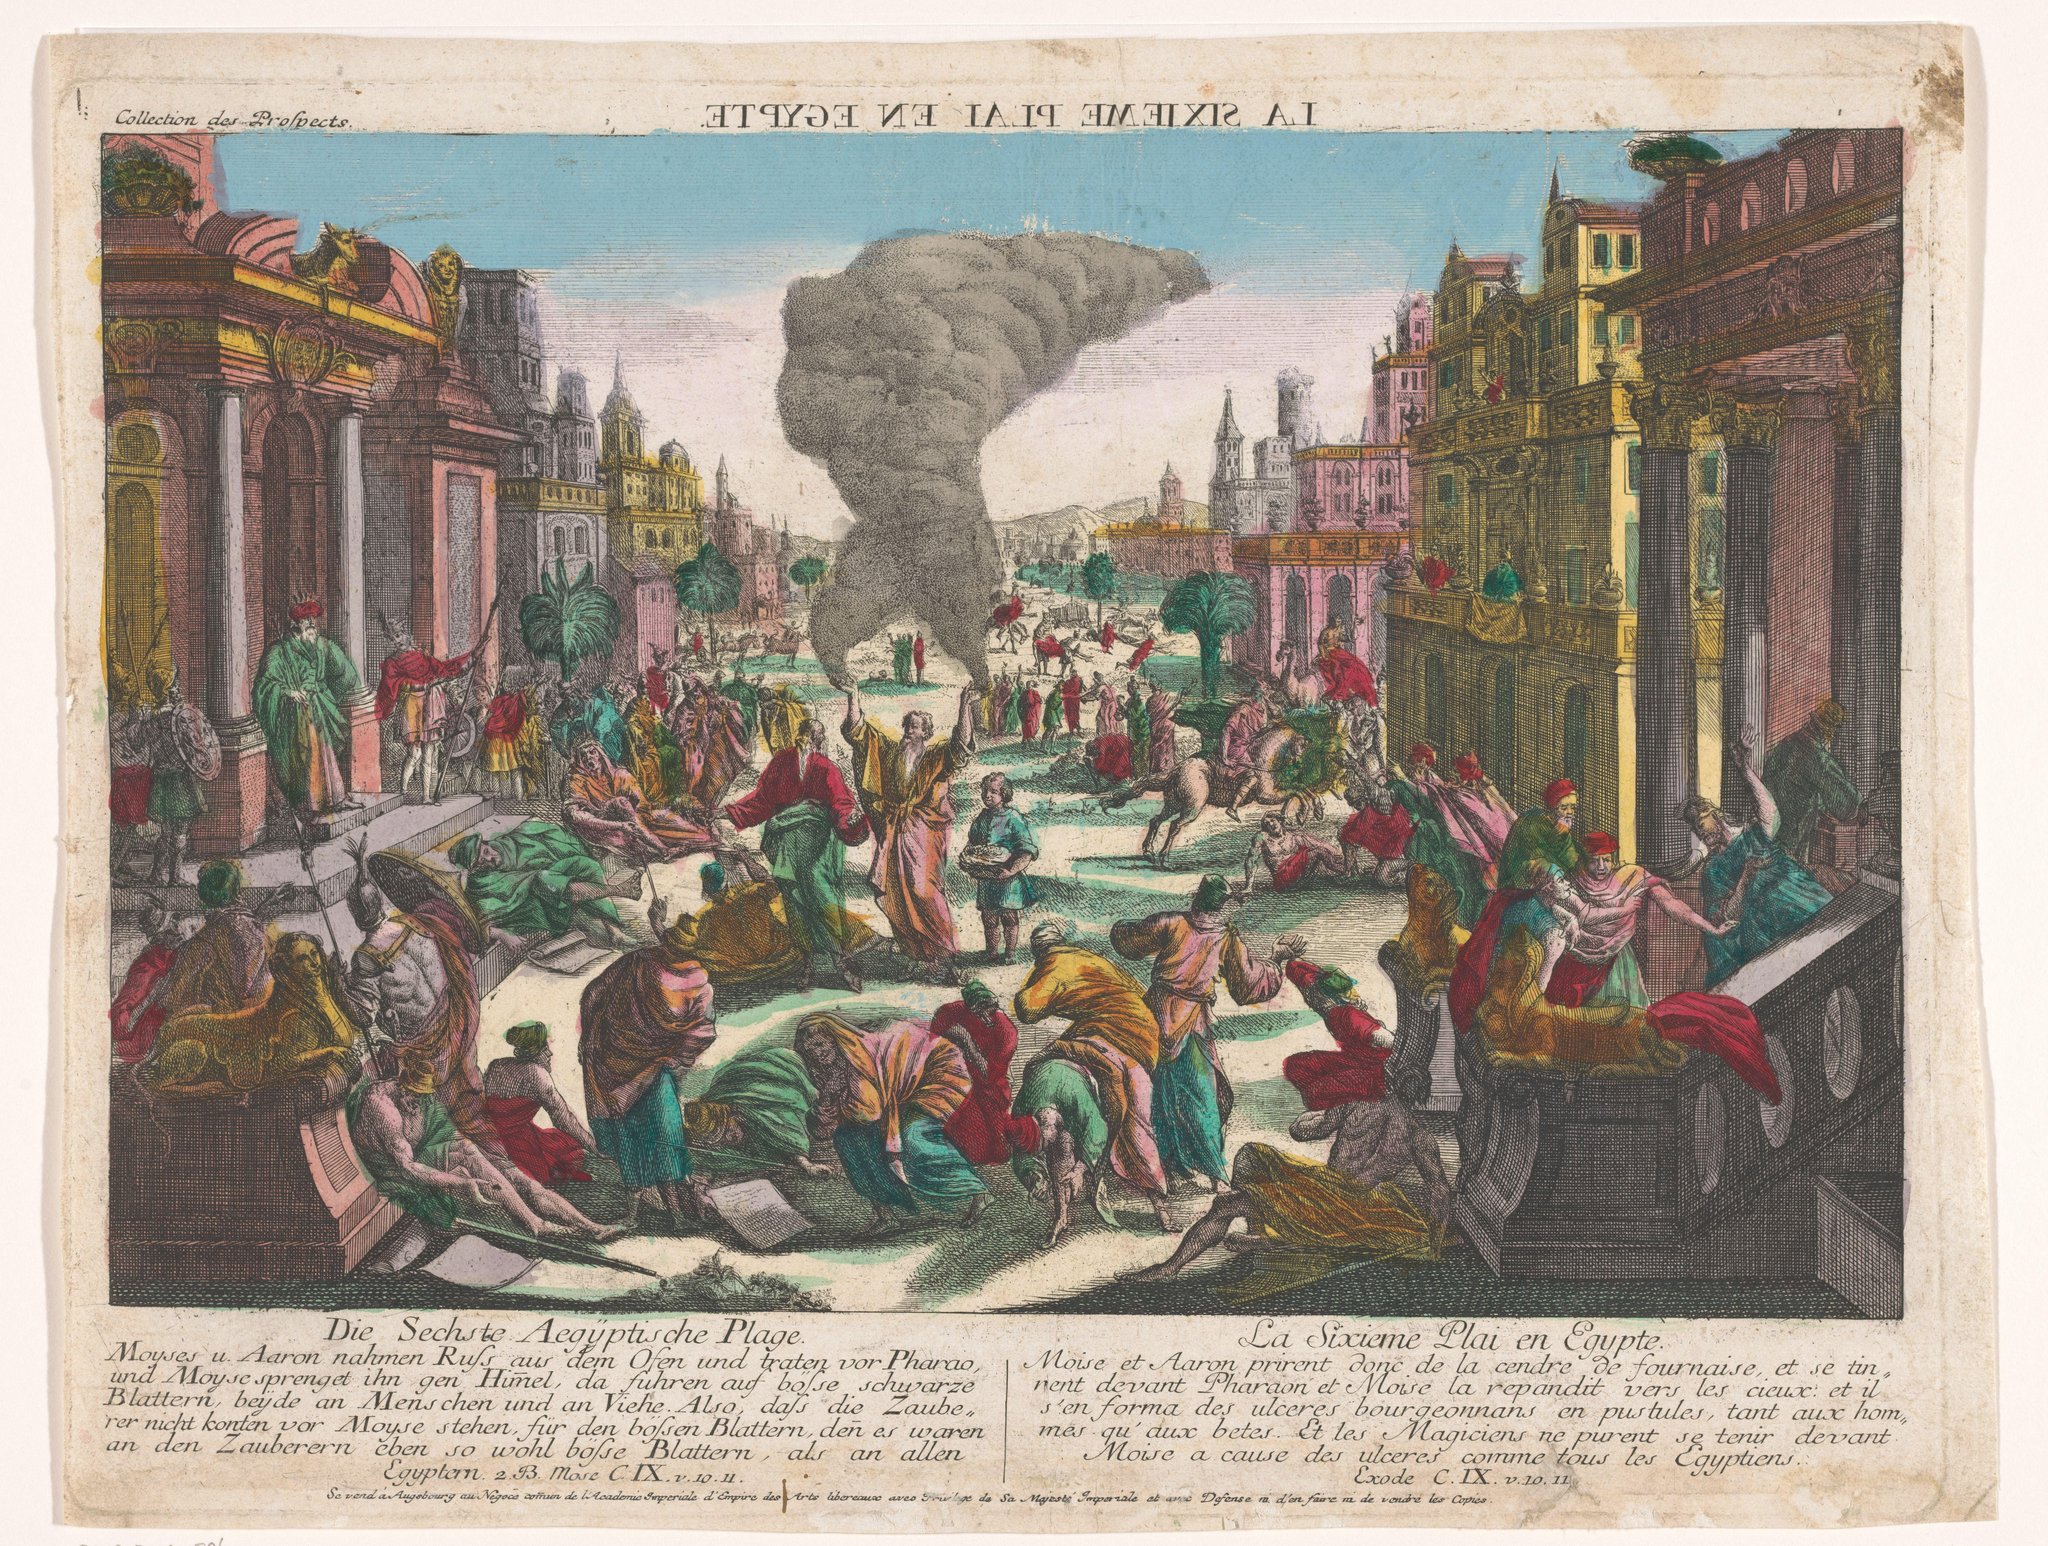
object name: print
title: Die sechste Aegyptische Plage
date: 1755-1779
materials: paper, watercolor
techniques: brush, etching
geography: germany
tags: the plague of boils: moses throws a handful of ashes into the air in front of pharaoh and it produces boils on the people and the animals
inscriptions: collector's mark: Lugt 2228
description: De plaag van de zweren. Uitzicht op een plein in een stad met een menigte mensen. In het midden staat Mozes die as omhoog gooit. De mensen krabben zich en tonen elkaar hun aangedane ledematen Onder de afbeelding uitleg in het Duits en het Frans.